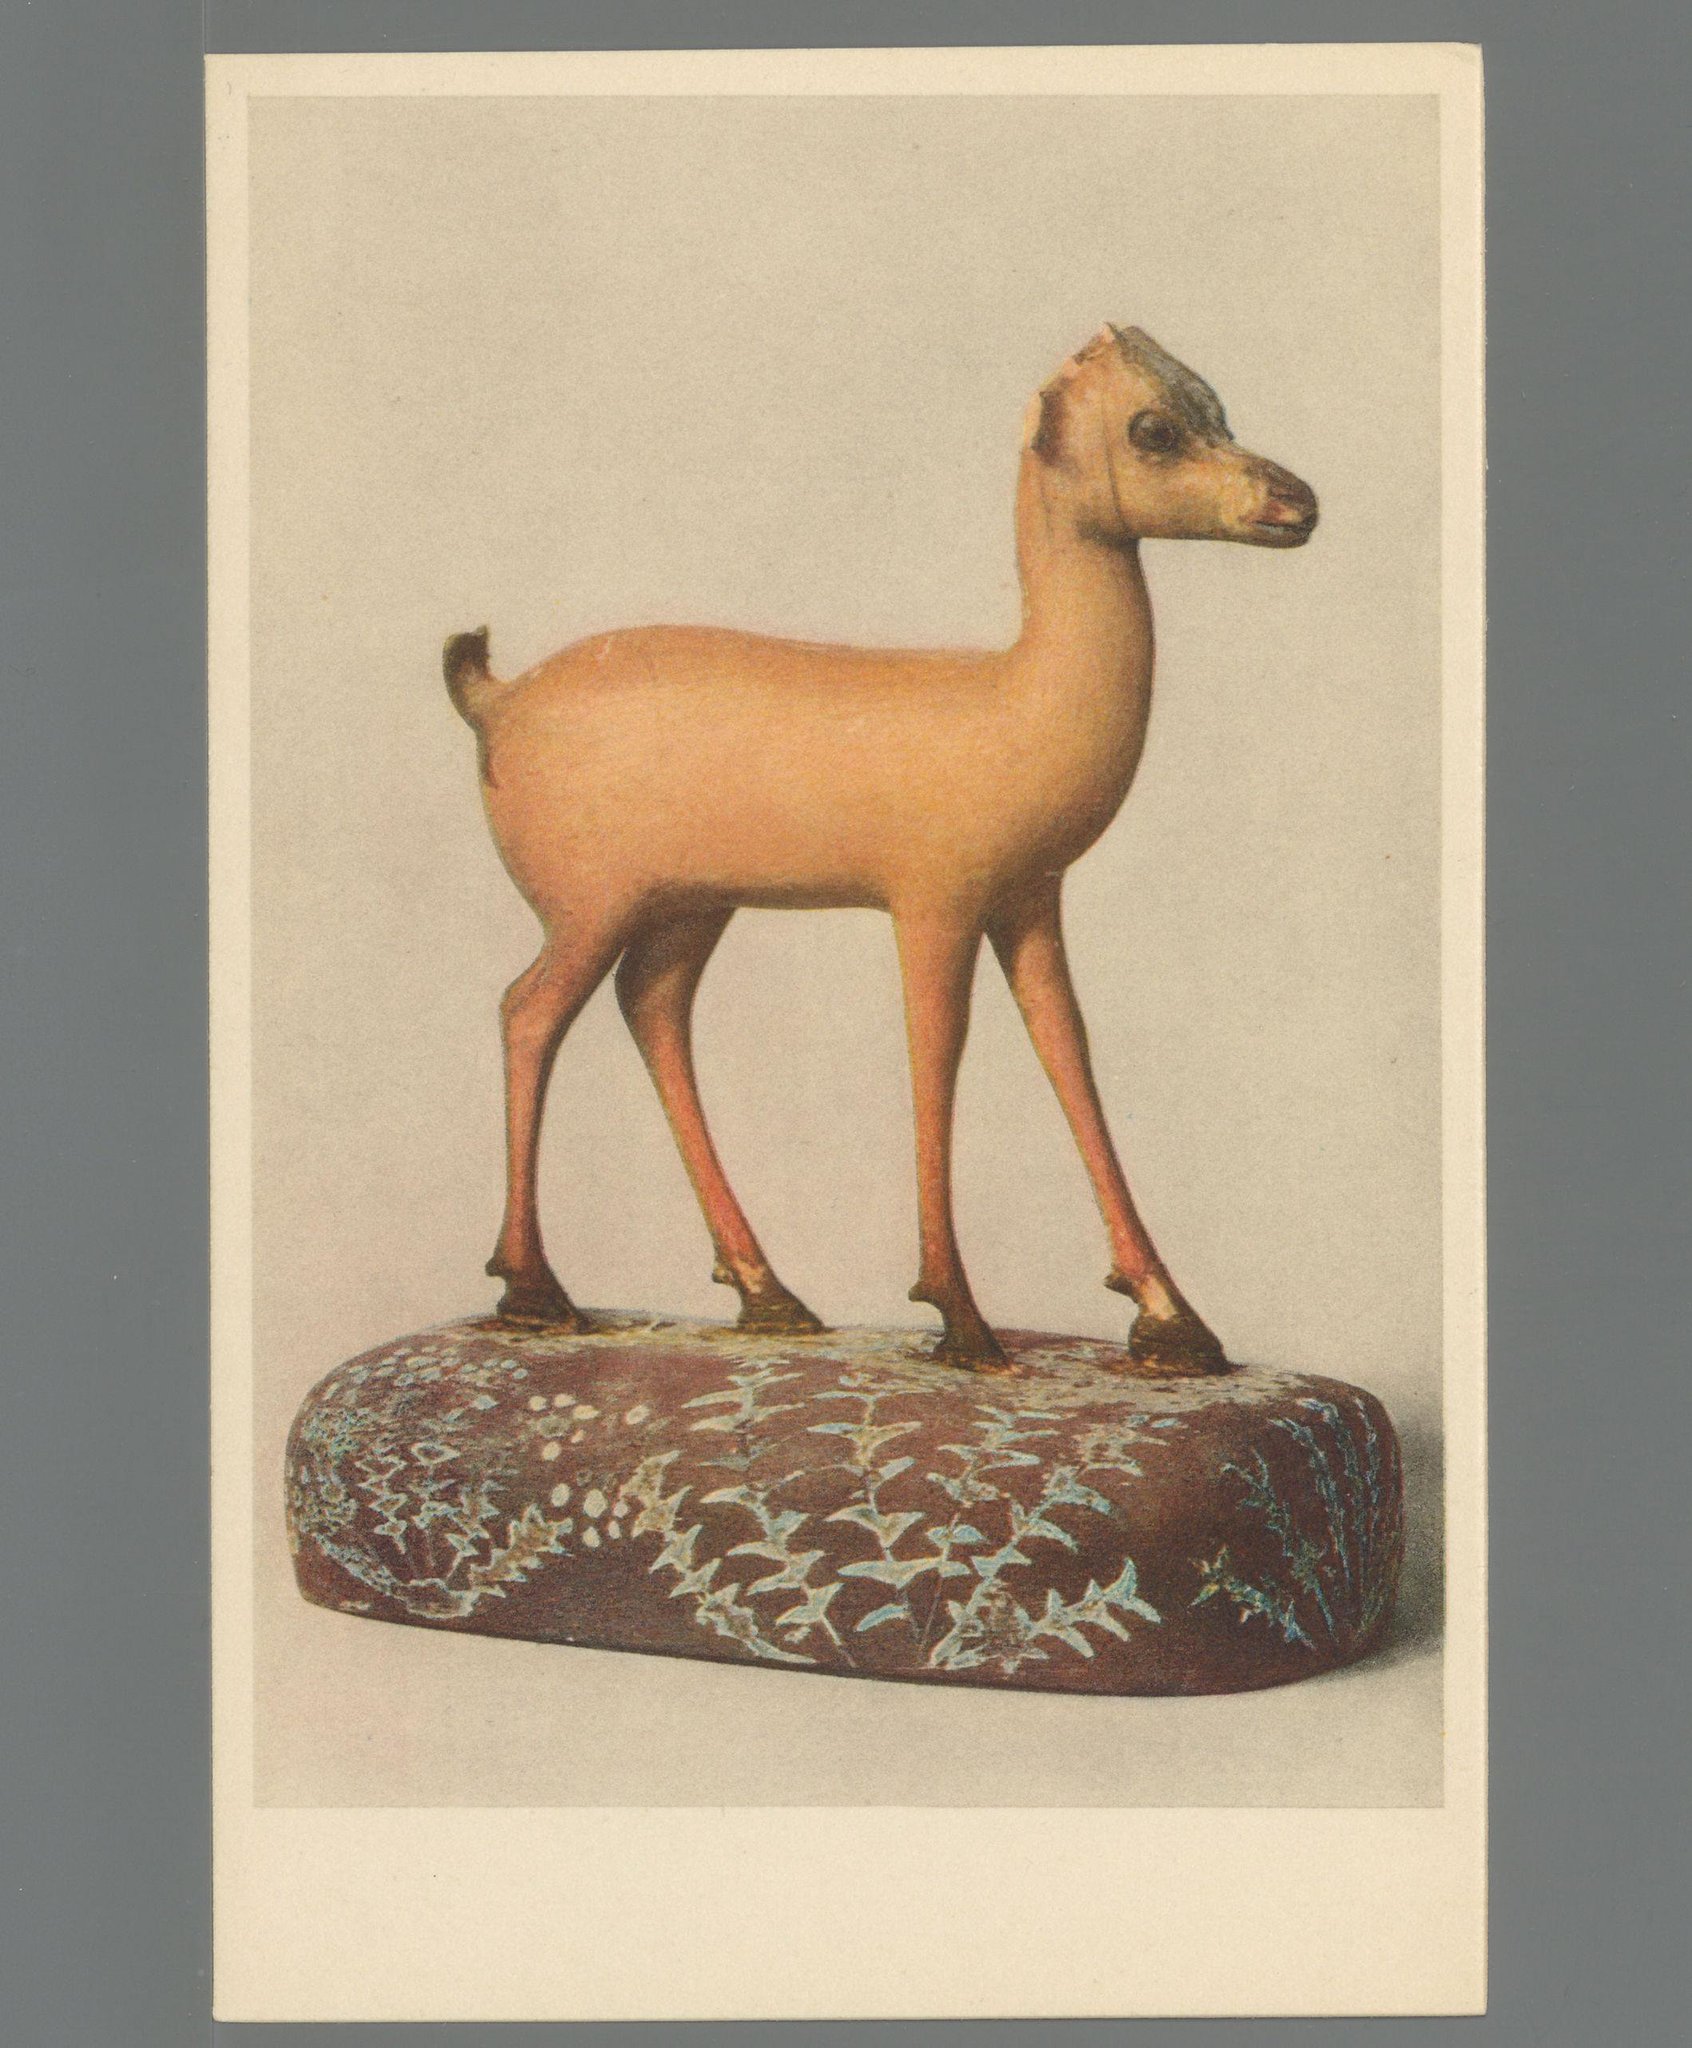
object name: photomechanical print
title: Ivory Figure of a Gazelle. Egyptian, about 1375 B.C. (XVIII Dynasty)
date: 1926-1940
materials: cardboard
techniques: photograph, lithograph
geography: vienna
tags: sculpture, hoofed animals: gazelle